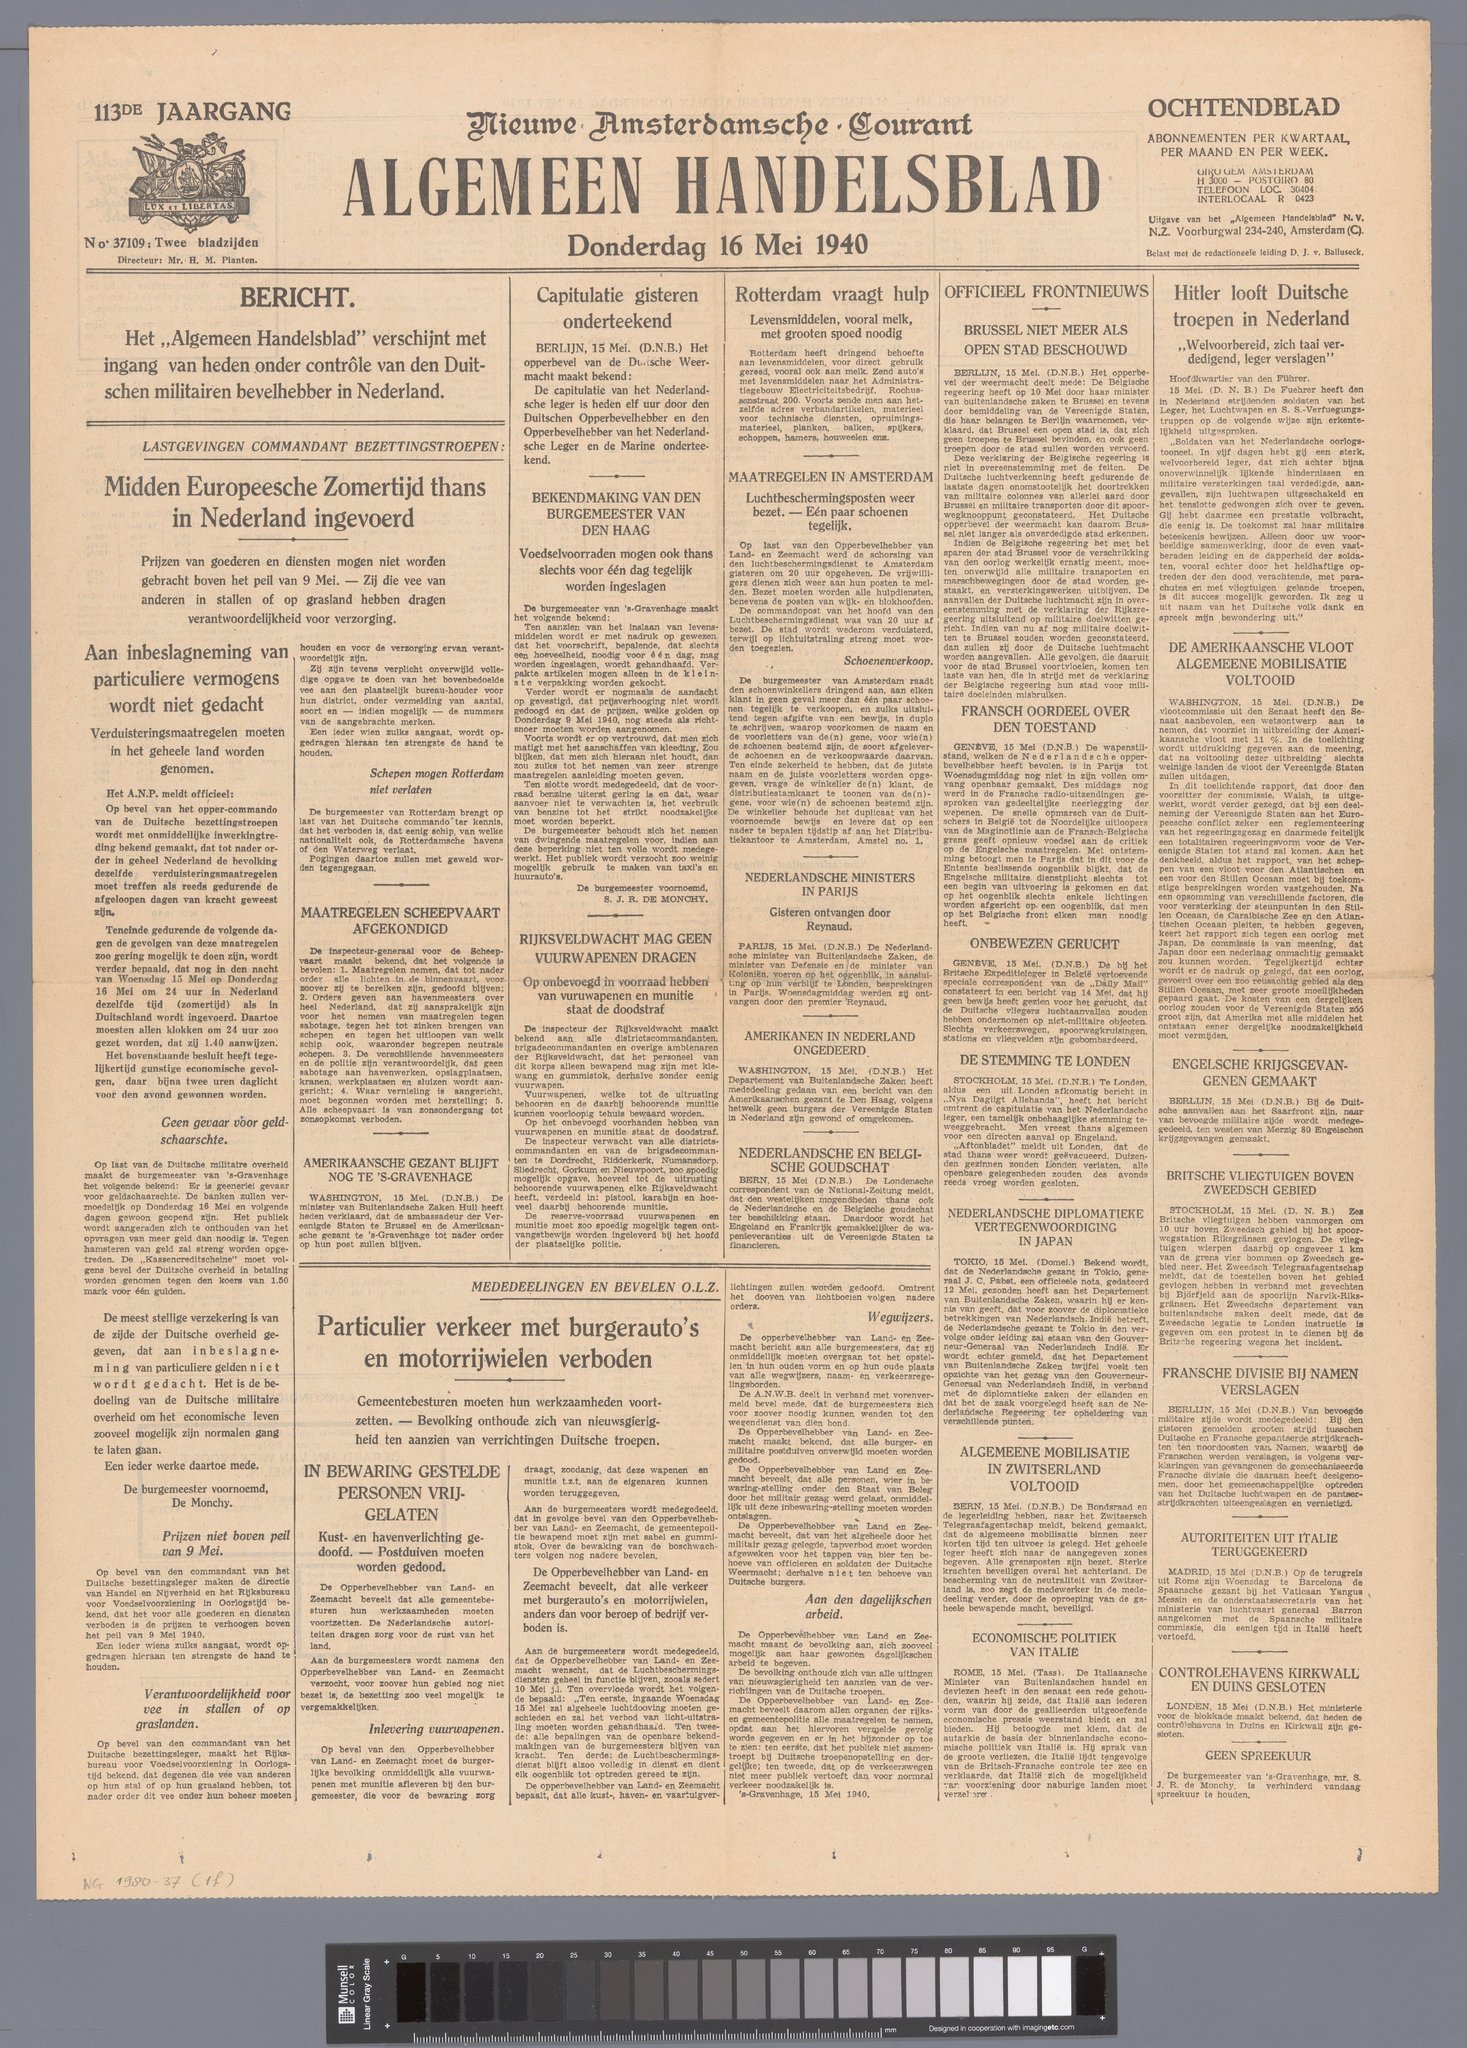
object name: newspaper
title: Algemeen Handelsblad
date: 1940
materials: paper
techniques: printing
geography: amsterdam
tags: netherlands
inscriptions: date